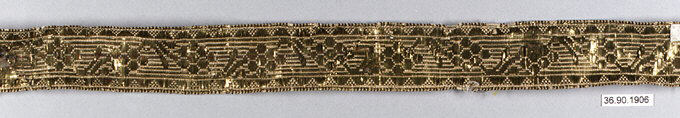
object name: galloon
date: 1767-1833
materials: silk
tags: flowers